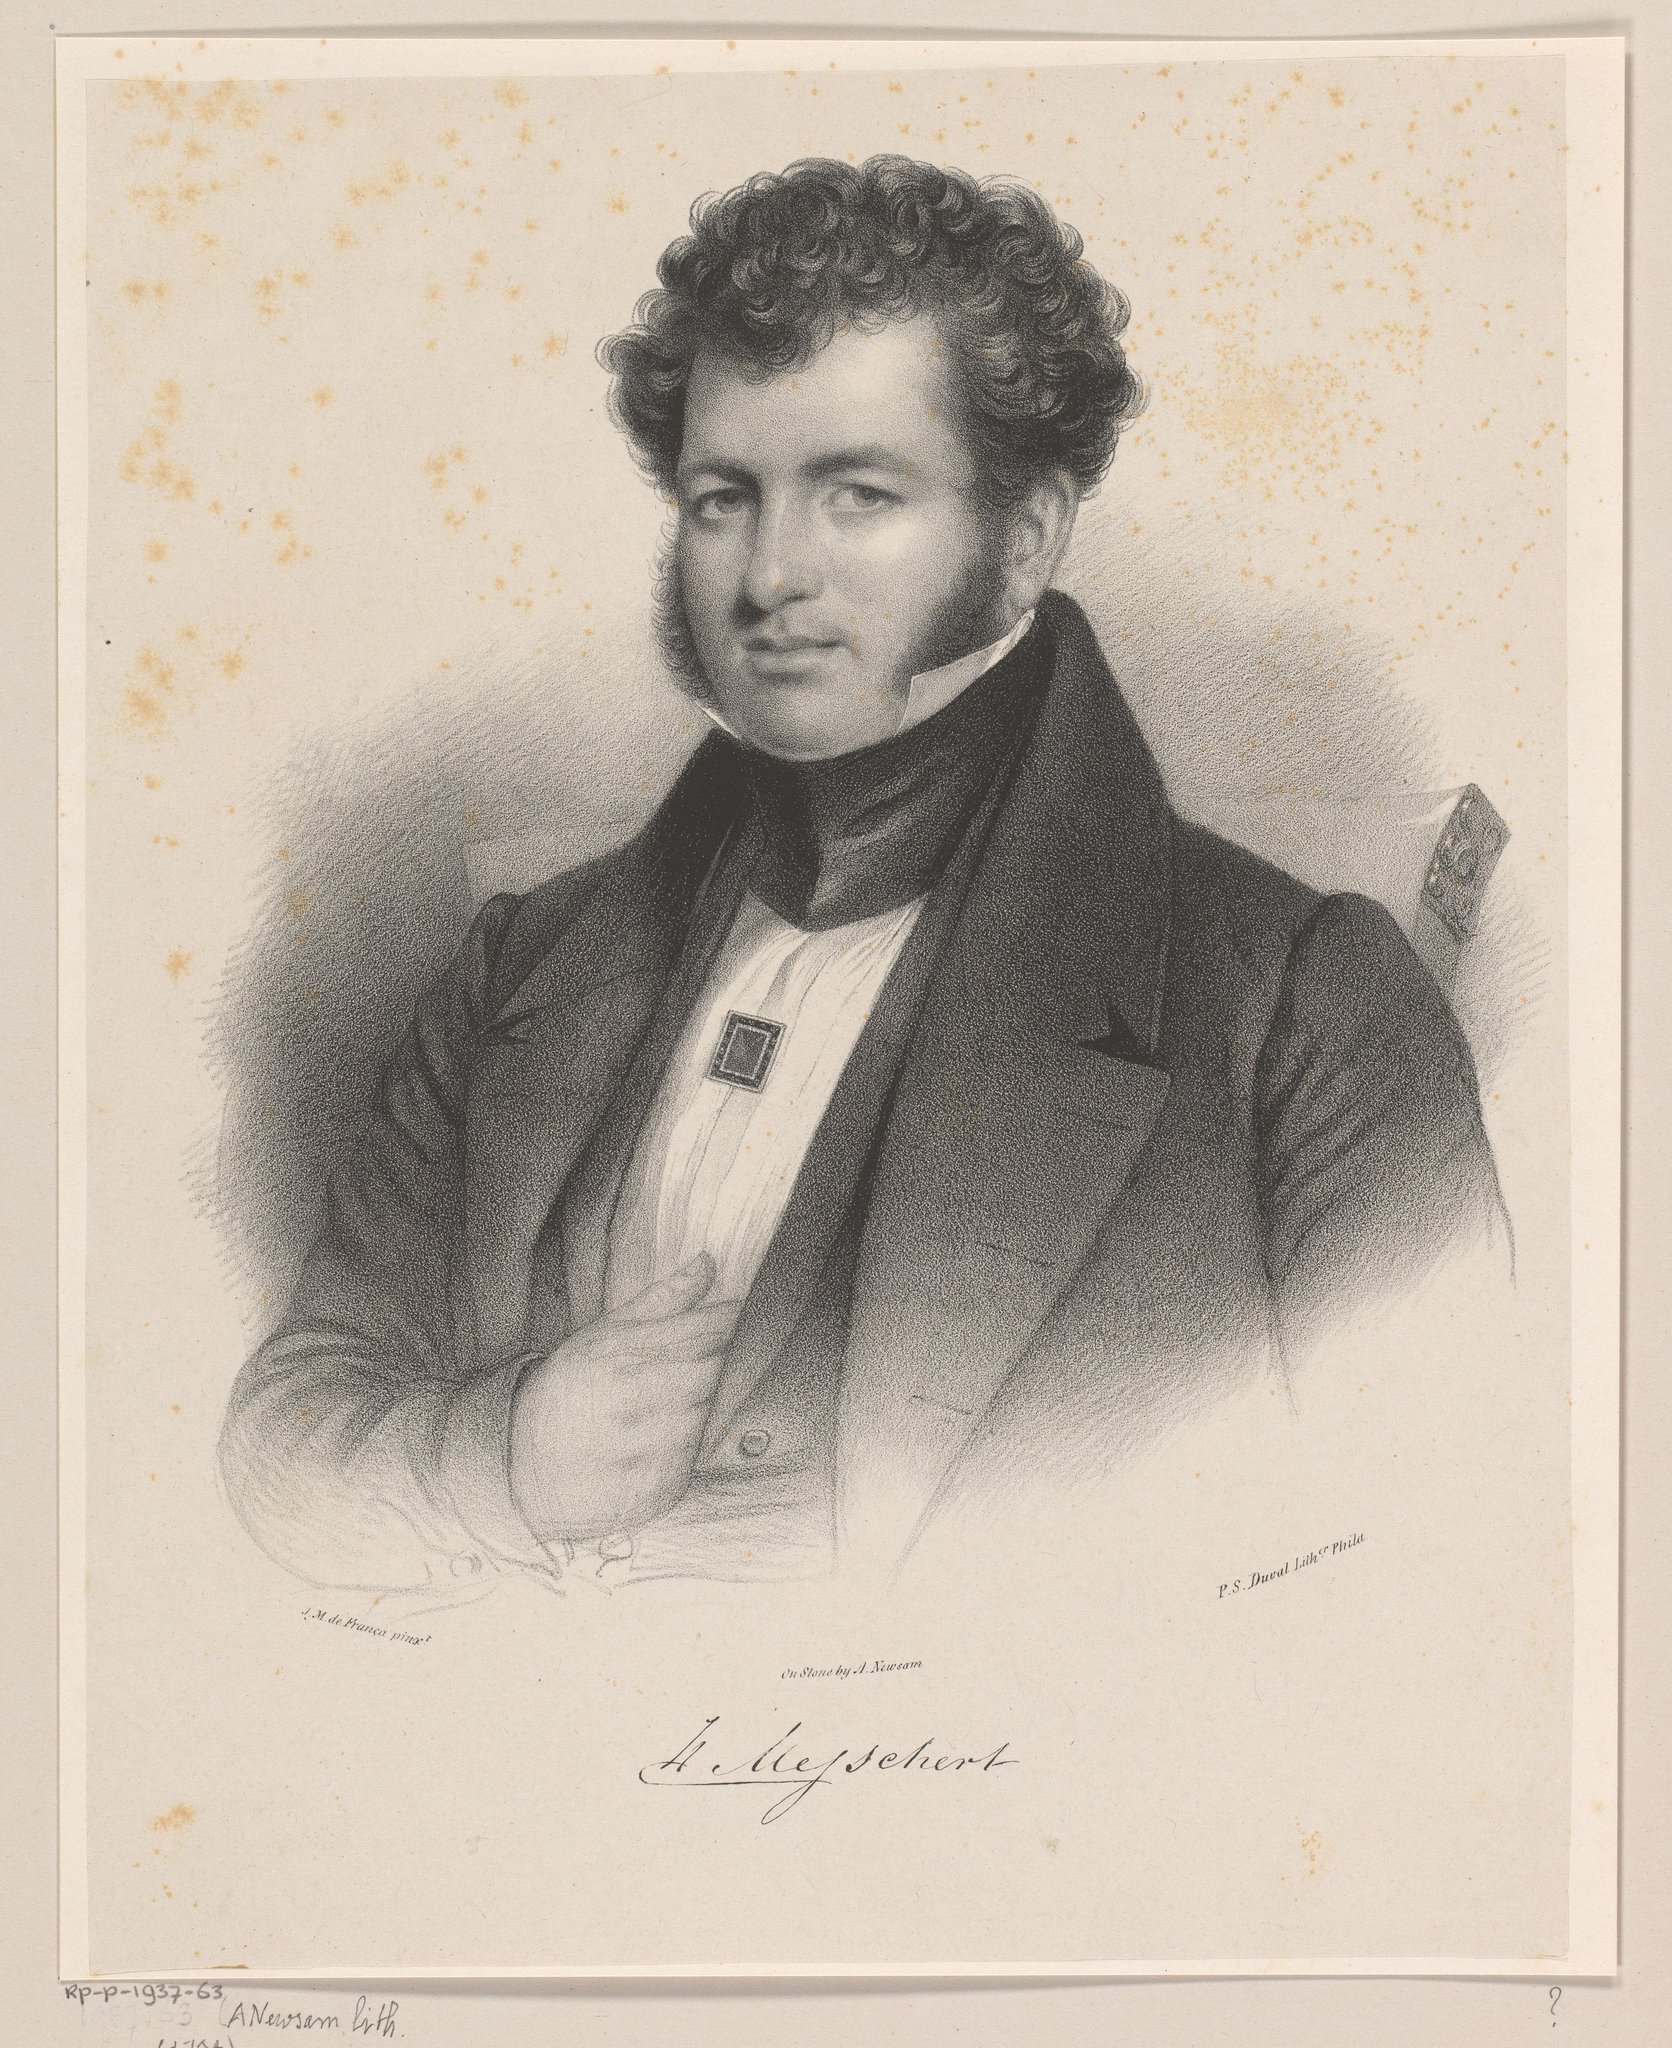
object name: print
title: Portret van Huizinga Messchert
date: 1831-1864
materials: paper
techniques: lithograph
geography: philadelphia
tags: historical persons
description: Met facsimile signatuur van de geportretteerde.